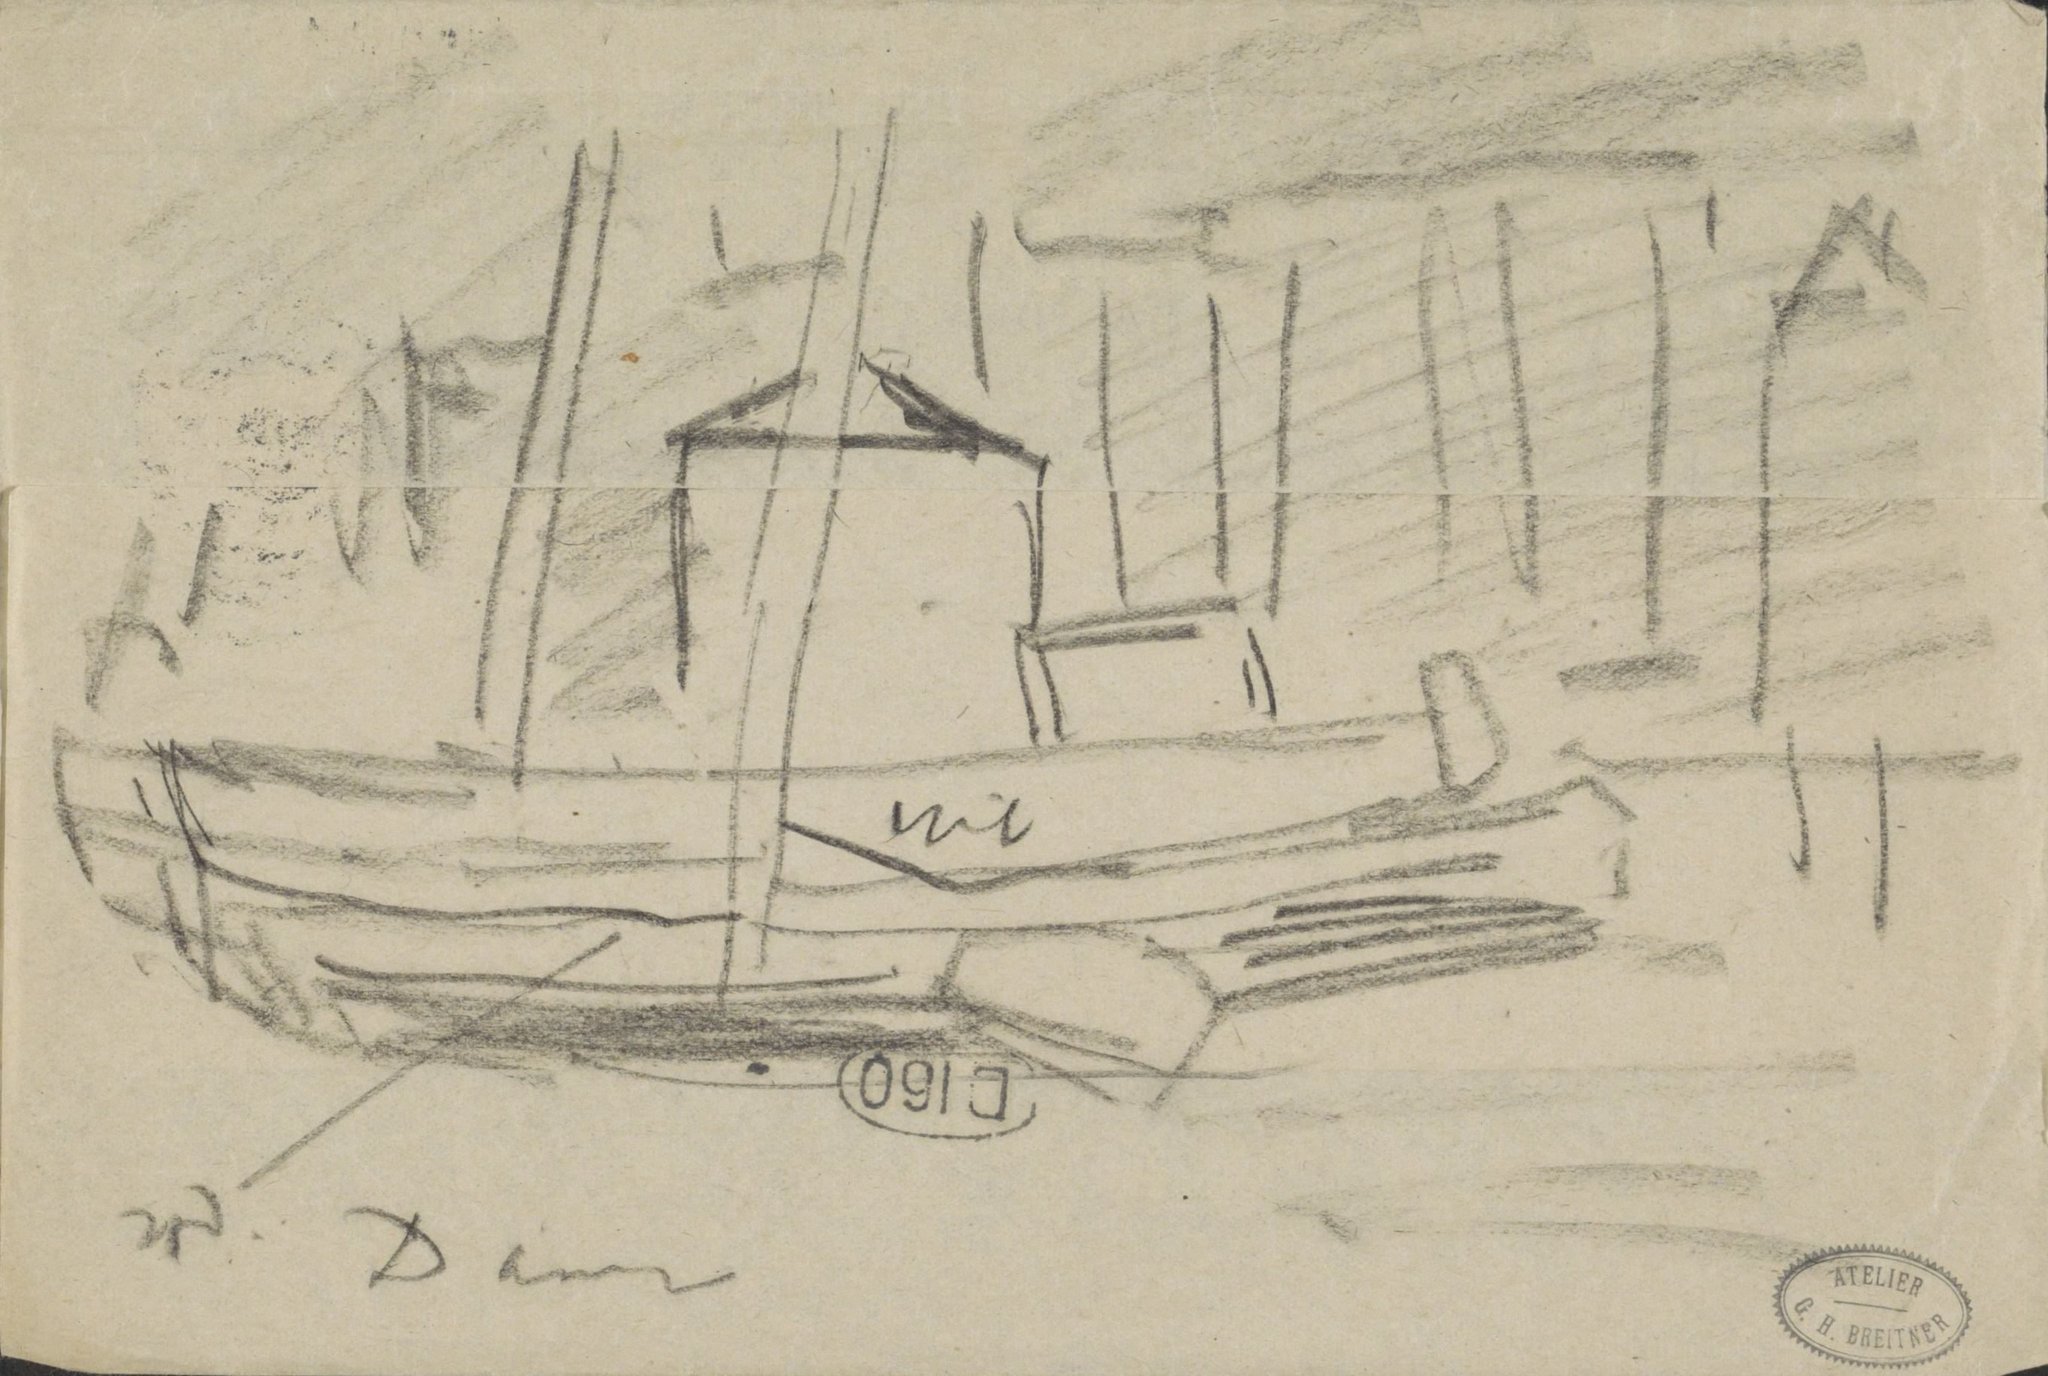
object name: drawing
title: Boten aan het Damrak te Amsterdam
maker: george hendrik breitner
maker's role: draughtsman, painter, print maker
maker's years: 1857-1923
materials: chalk, paper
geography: amsterdam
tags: ships (in general), canals, waters (in city)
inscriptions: :, annotation: ‘Dam’, workshop stamp: Lugt 291d, collector's mark: Lugt 2228, stamp: ‘D160’, annotation: ‘Tijdschrift van den Nederlandschen Schaakbond./ [...]/ Maandblad/ Den Heer G.H. Breitner/ s.s.t.t./ Prinseneiland 24B/ Amsterdam/ [...]’